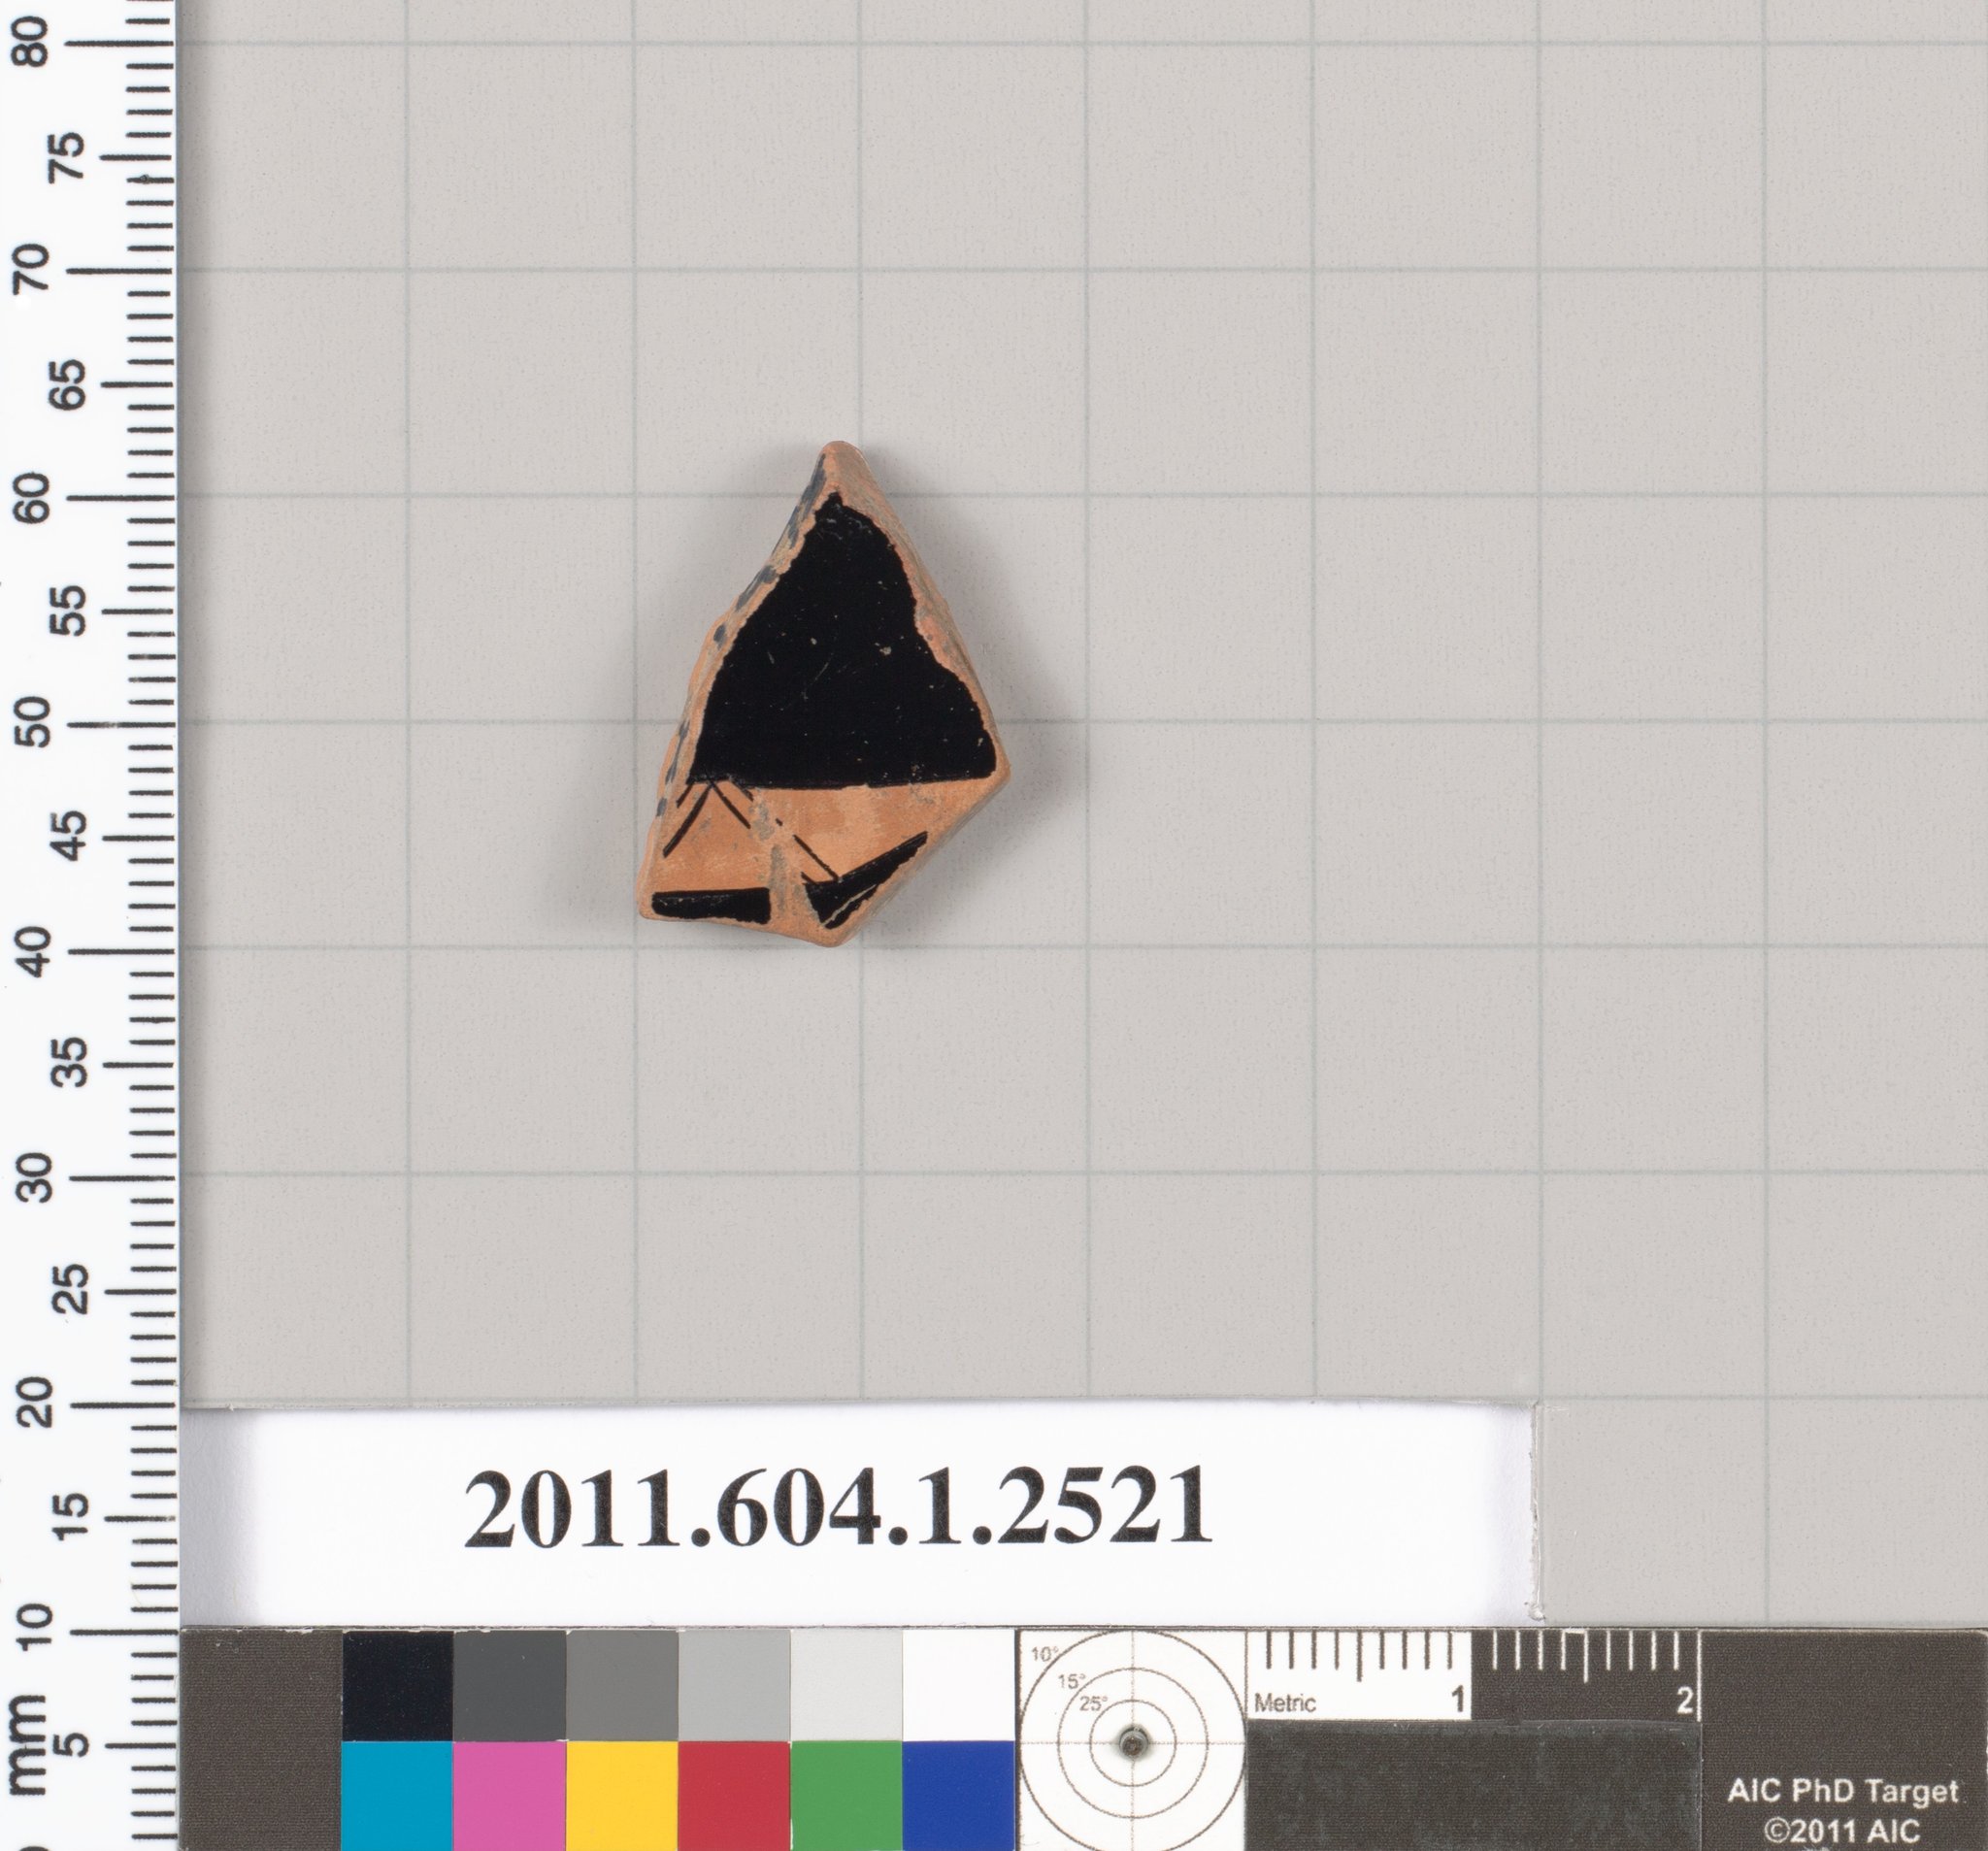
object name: kylix fragment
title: Terracotta fragment of a kylix (drinking cup)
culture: greek, attic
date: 475-451 BCE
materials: terracotta